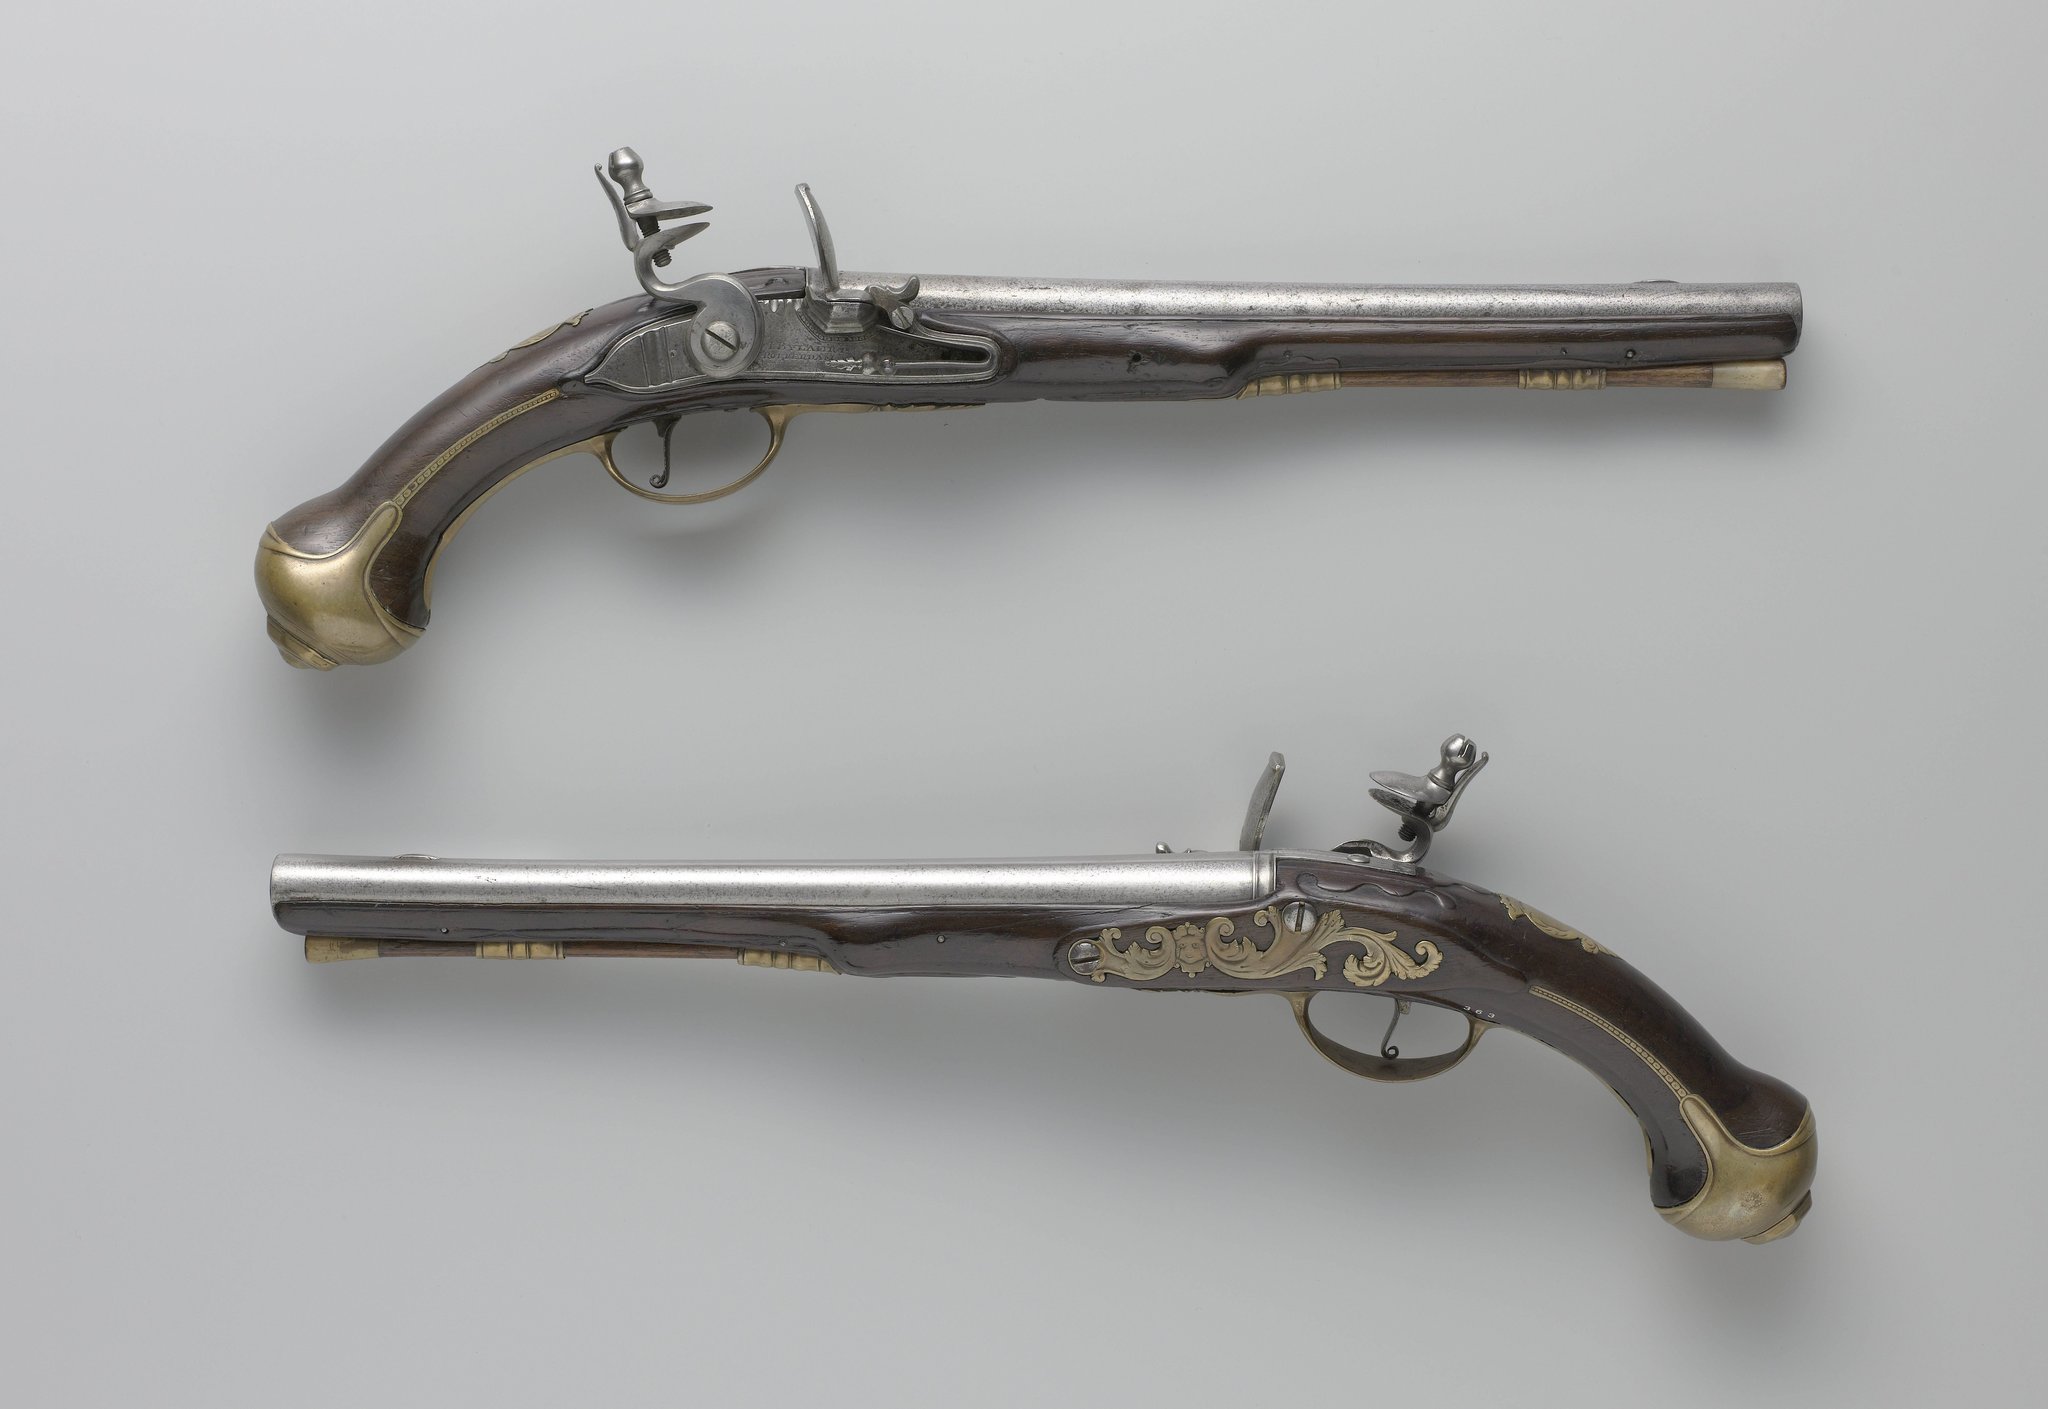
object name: flintlock pistol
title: vuursteenpistool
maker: jan bijlaard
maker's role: geweermaker, pistoolmaker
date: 1700-1708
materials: brass, horn, iron, wood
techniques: printing, metalworking, cutting, engraving, gilding, relief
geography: rotterdam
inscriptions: inscription: ‘I=BYLAERT // ROTTERDAM’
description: Tentoongesteld in: Stedelijk Museum De Lakenhal, Leiden, juli-sept 1978.